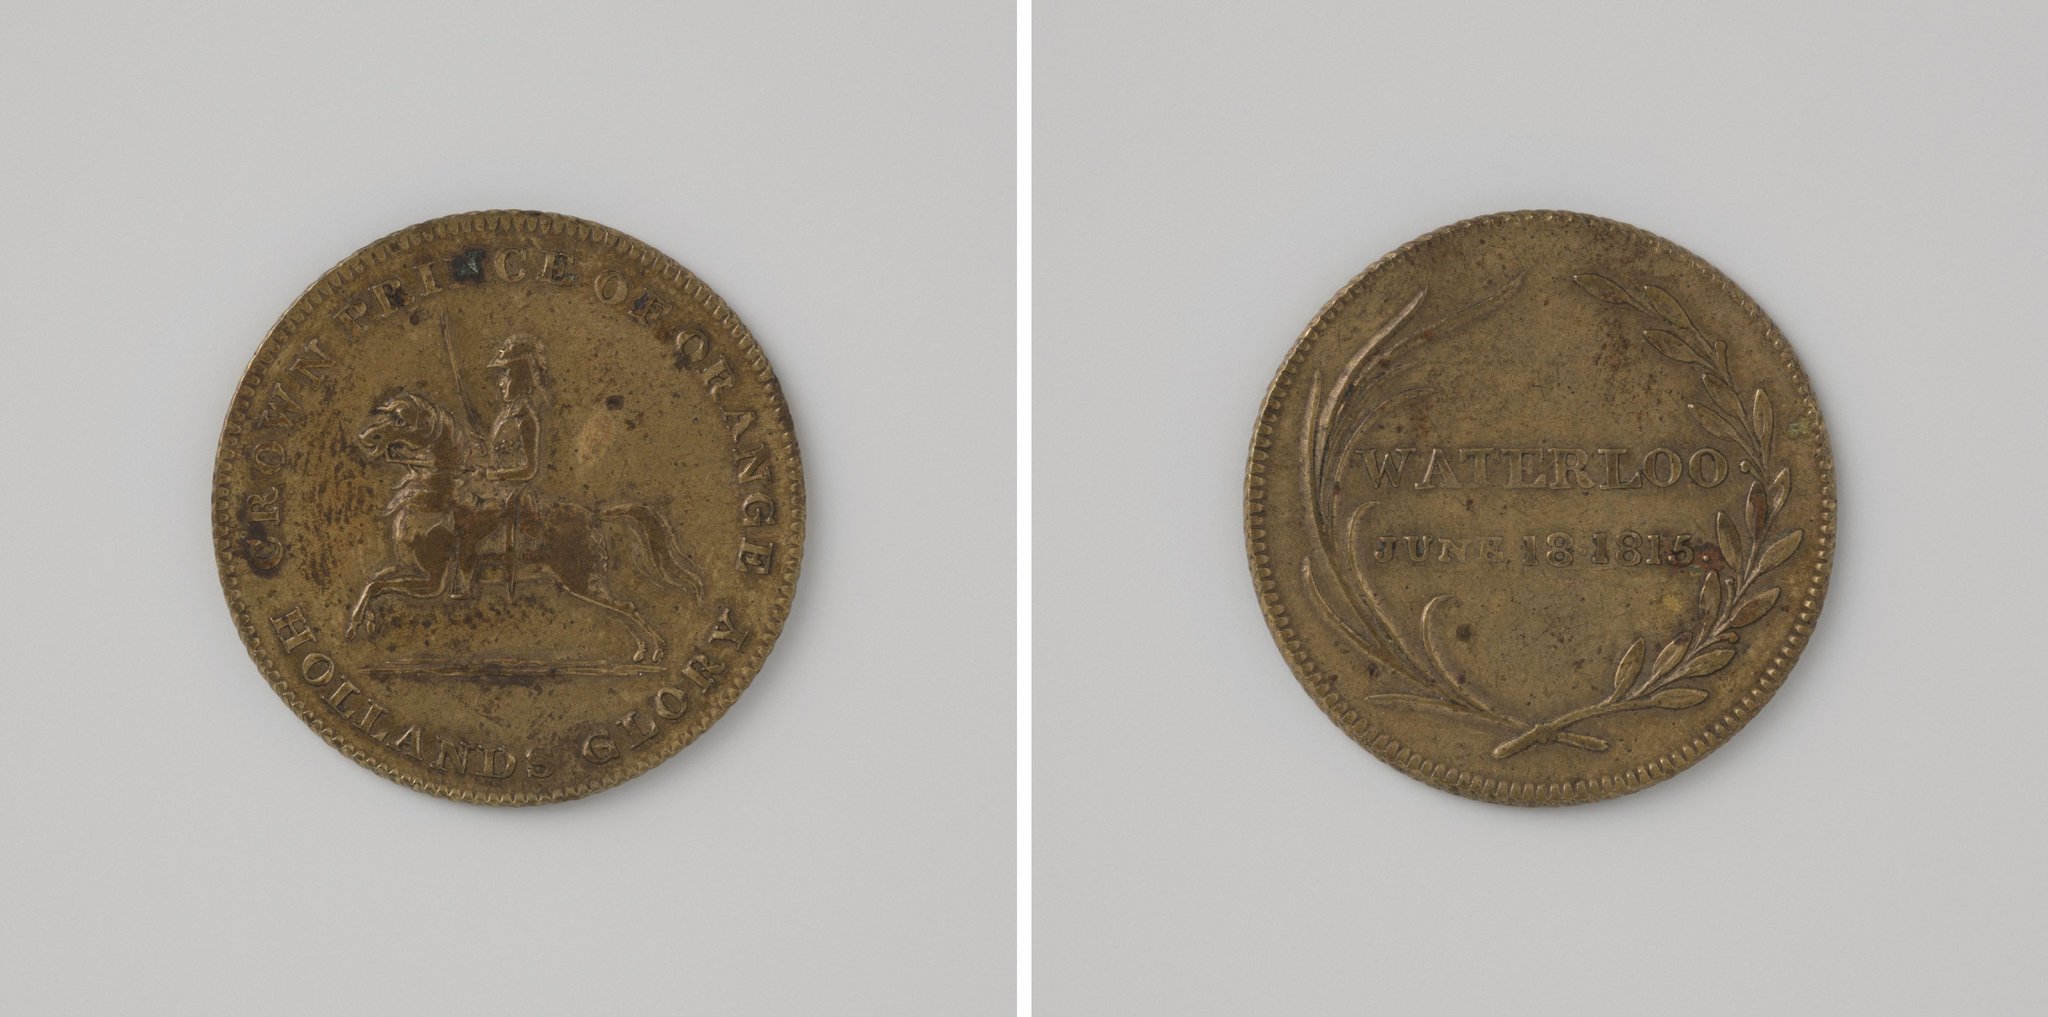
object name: history medal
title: De Kroonprins van Oranje in de Slag bij Waterloo 1815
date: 1815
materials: brass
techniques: striking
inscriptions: circumscription: ‘CROWN PRINCE OF ORANGE / HOLLANDS GLORY’, inscription: ‘WATERLOO / JUNE 18. 1815.’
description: Messing penning, op de voorzijde de kroonprins met blanke sabel te paard naar links, met omschrift, op de keerzijde twee regels tekst tussen palm- en lauwertak, Engelstalig.